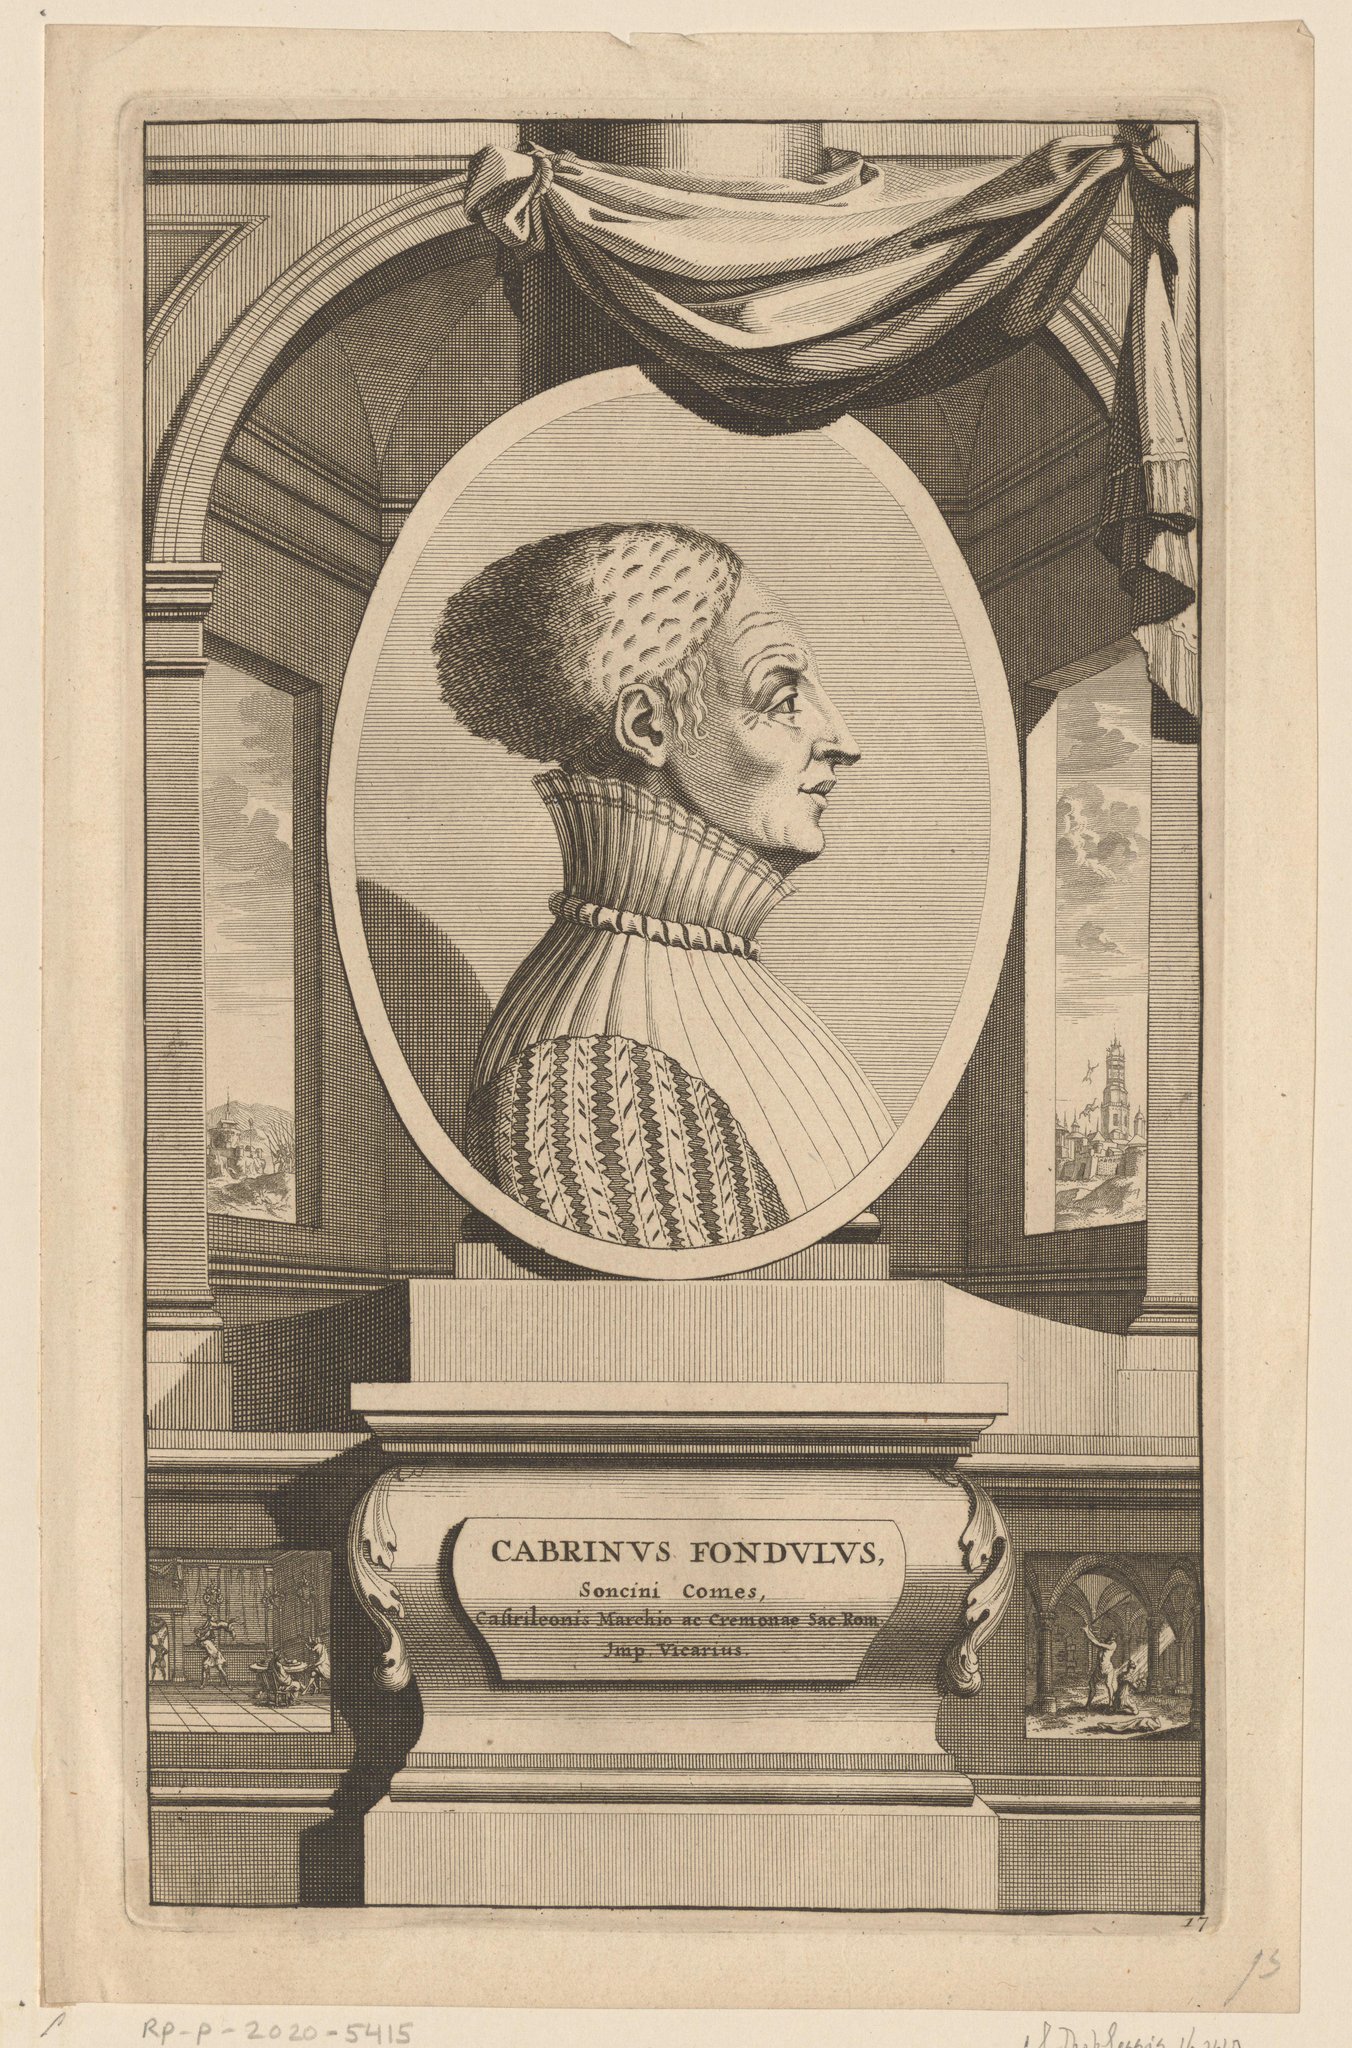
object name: print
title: Portret van Gabrino Fondulo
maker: Anonymous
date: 1704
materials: paper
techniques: etching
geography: northern netherlands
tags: (feigned) picture curtain, historical persons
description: Prent in eerdere staat gebruikt in: Graevius, Joannes Georgius. Thesaurus antiquitatum et historiarum Italiae (...). Leiden: Pieter van der Aa, 1704, dl. 3-1.